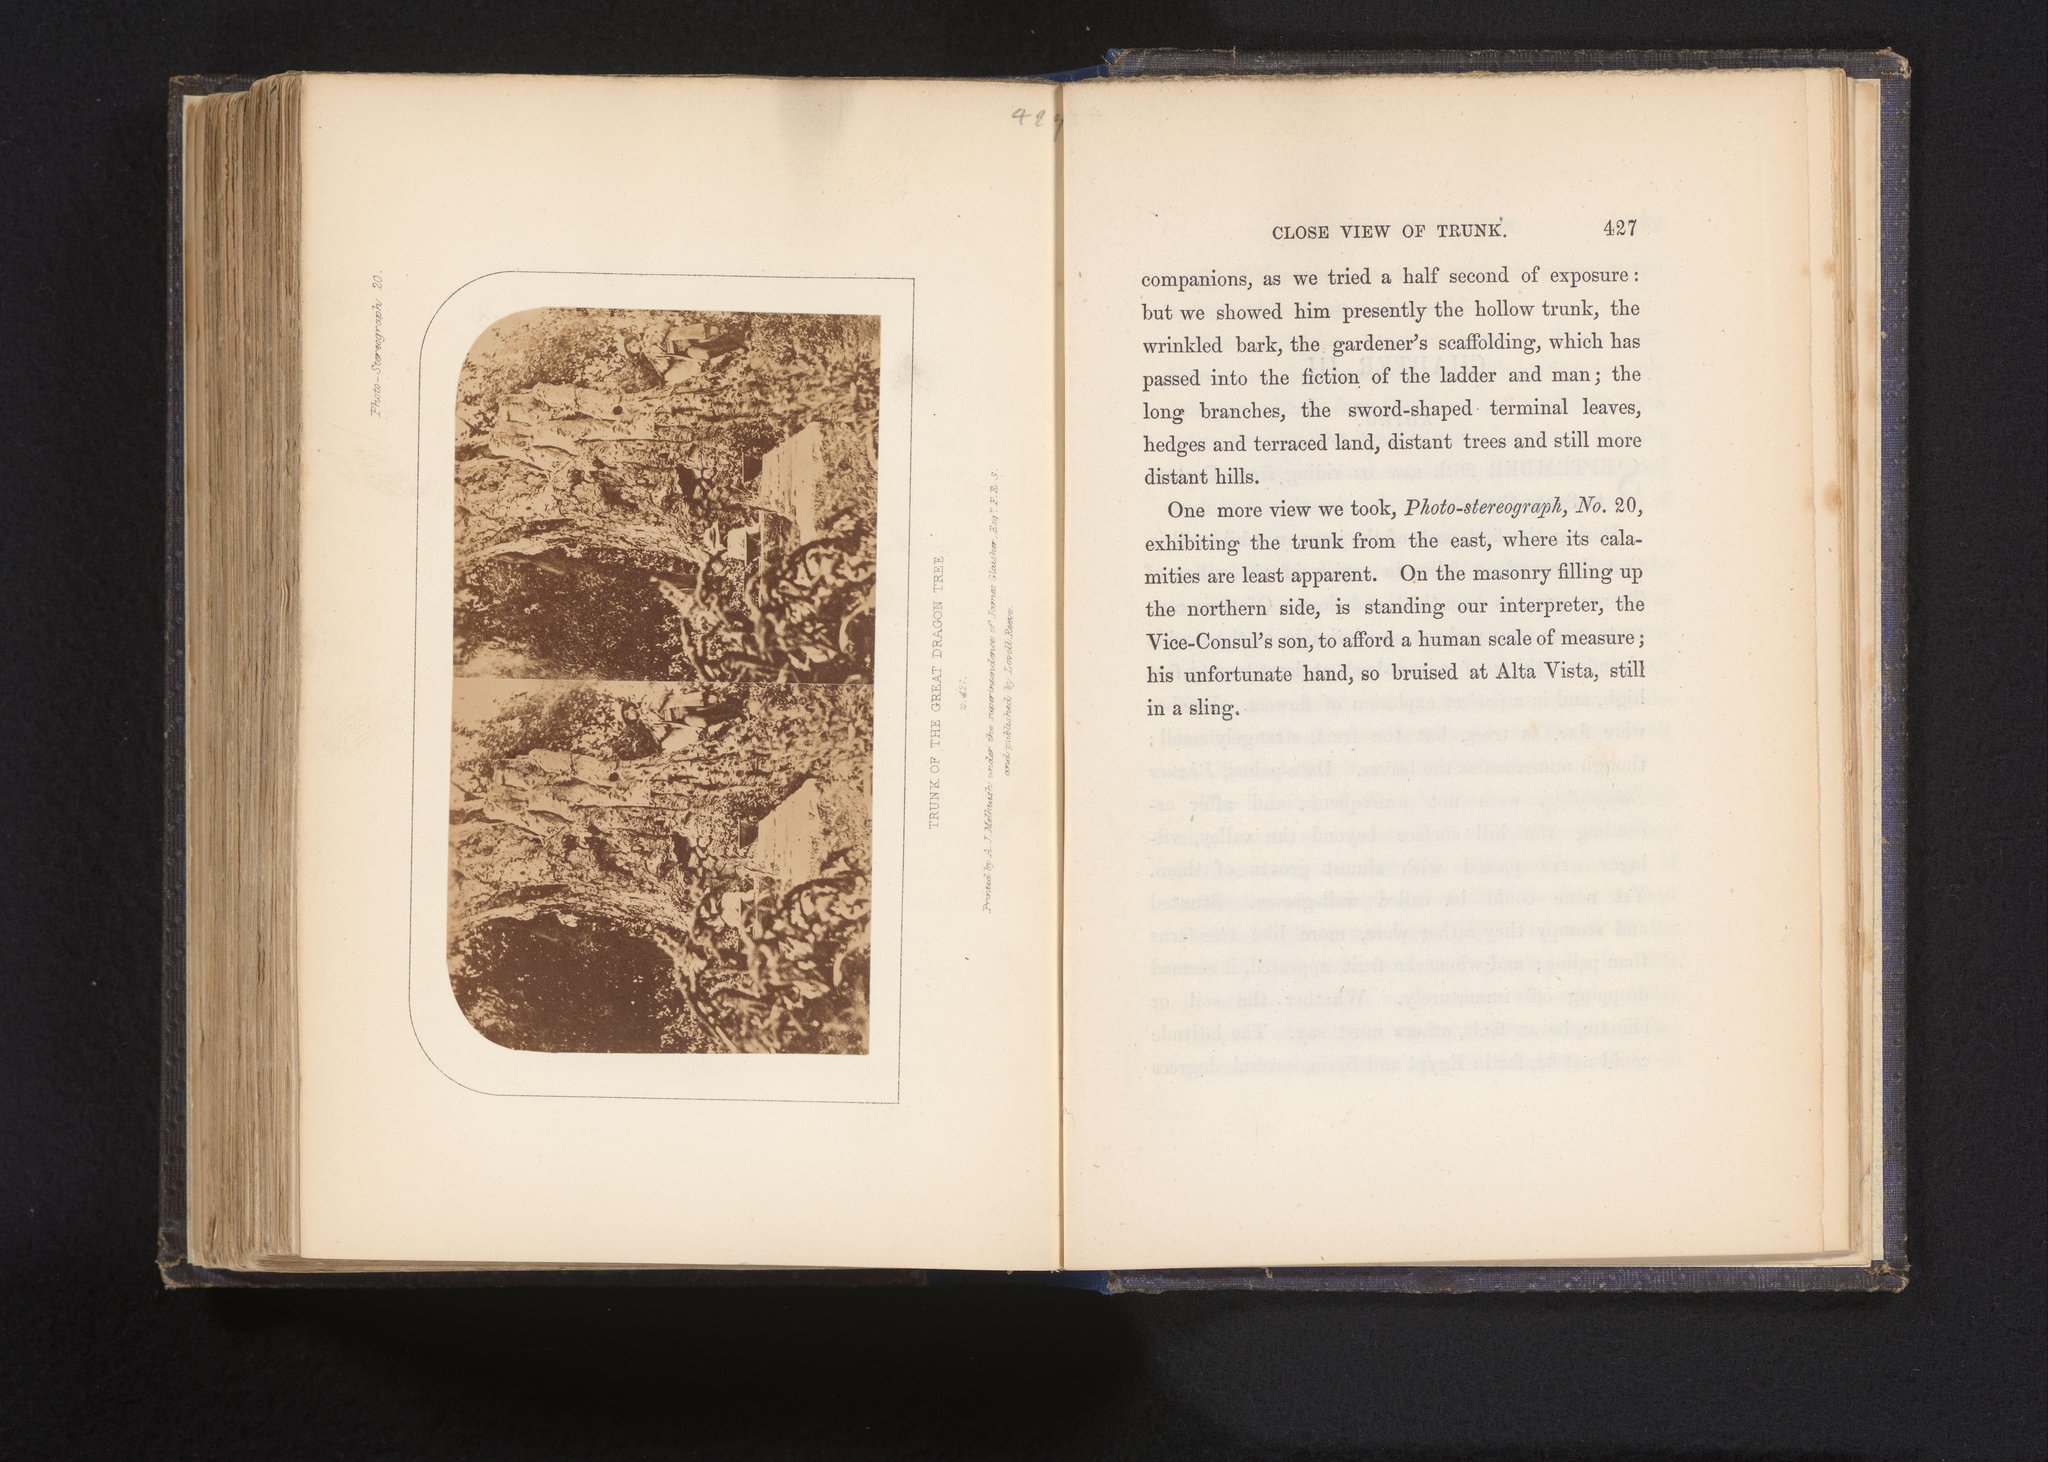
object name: page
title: Stam van de drakenbloedboom bij La Orotava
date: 1856-1858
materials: paper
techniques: albumen print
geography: la orotava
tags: trees (+ stem, trunk)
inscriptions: inscription: ‘Photo-Stereograph 20.’